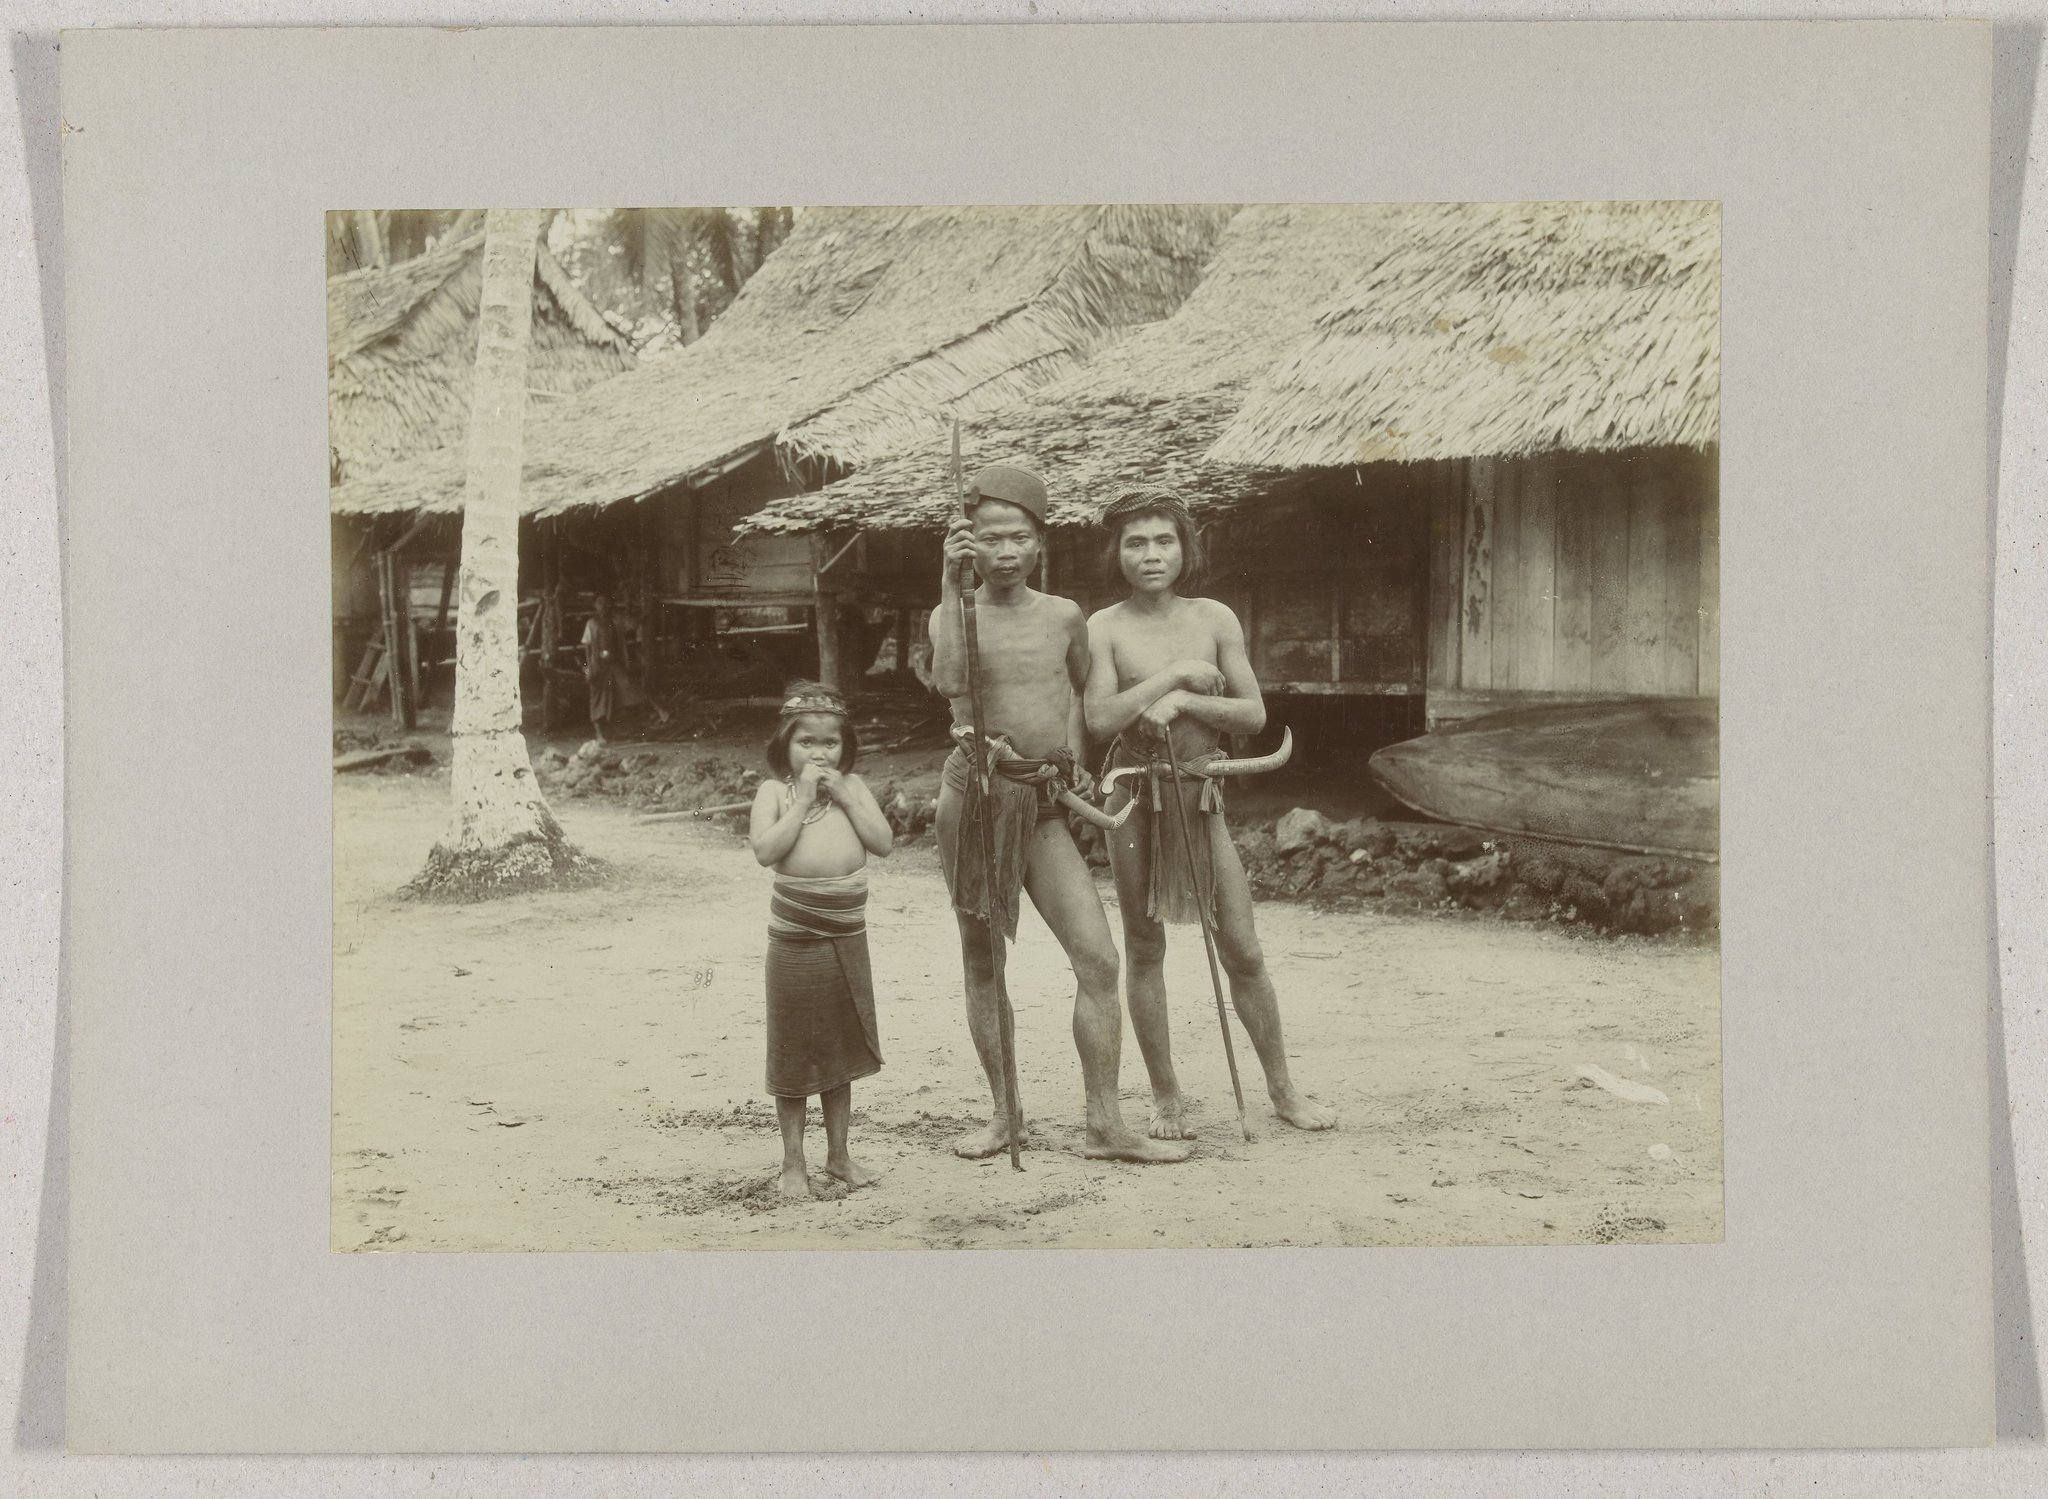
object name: photograph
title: 12. Niassers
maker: Anonymous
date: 1895-1915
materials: cardboard, paper, photographic support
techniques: gelatin silver print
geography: dutch east indies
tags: indonesia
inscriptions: annotation: ‘12. Niassers’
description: Twee mannen en een kind, Nias, Nederlands-Indië